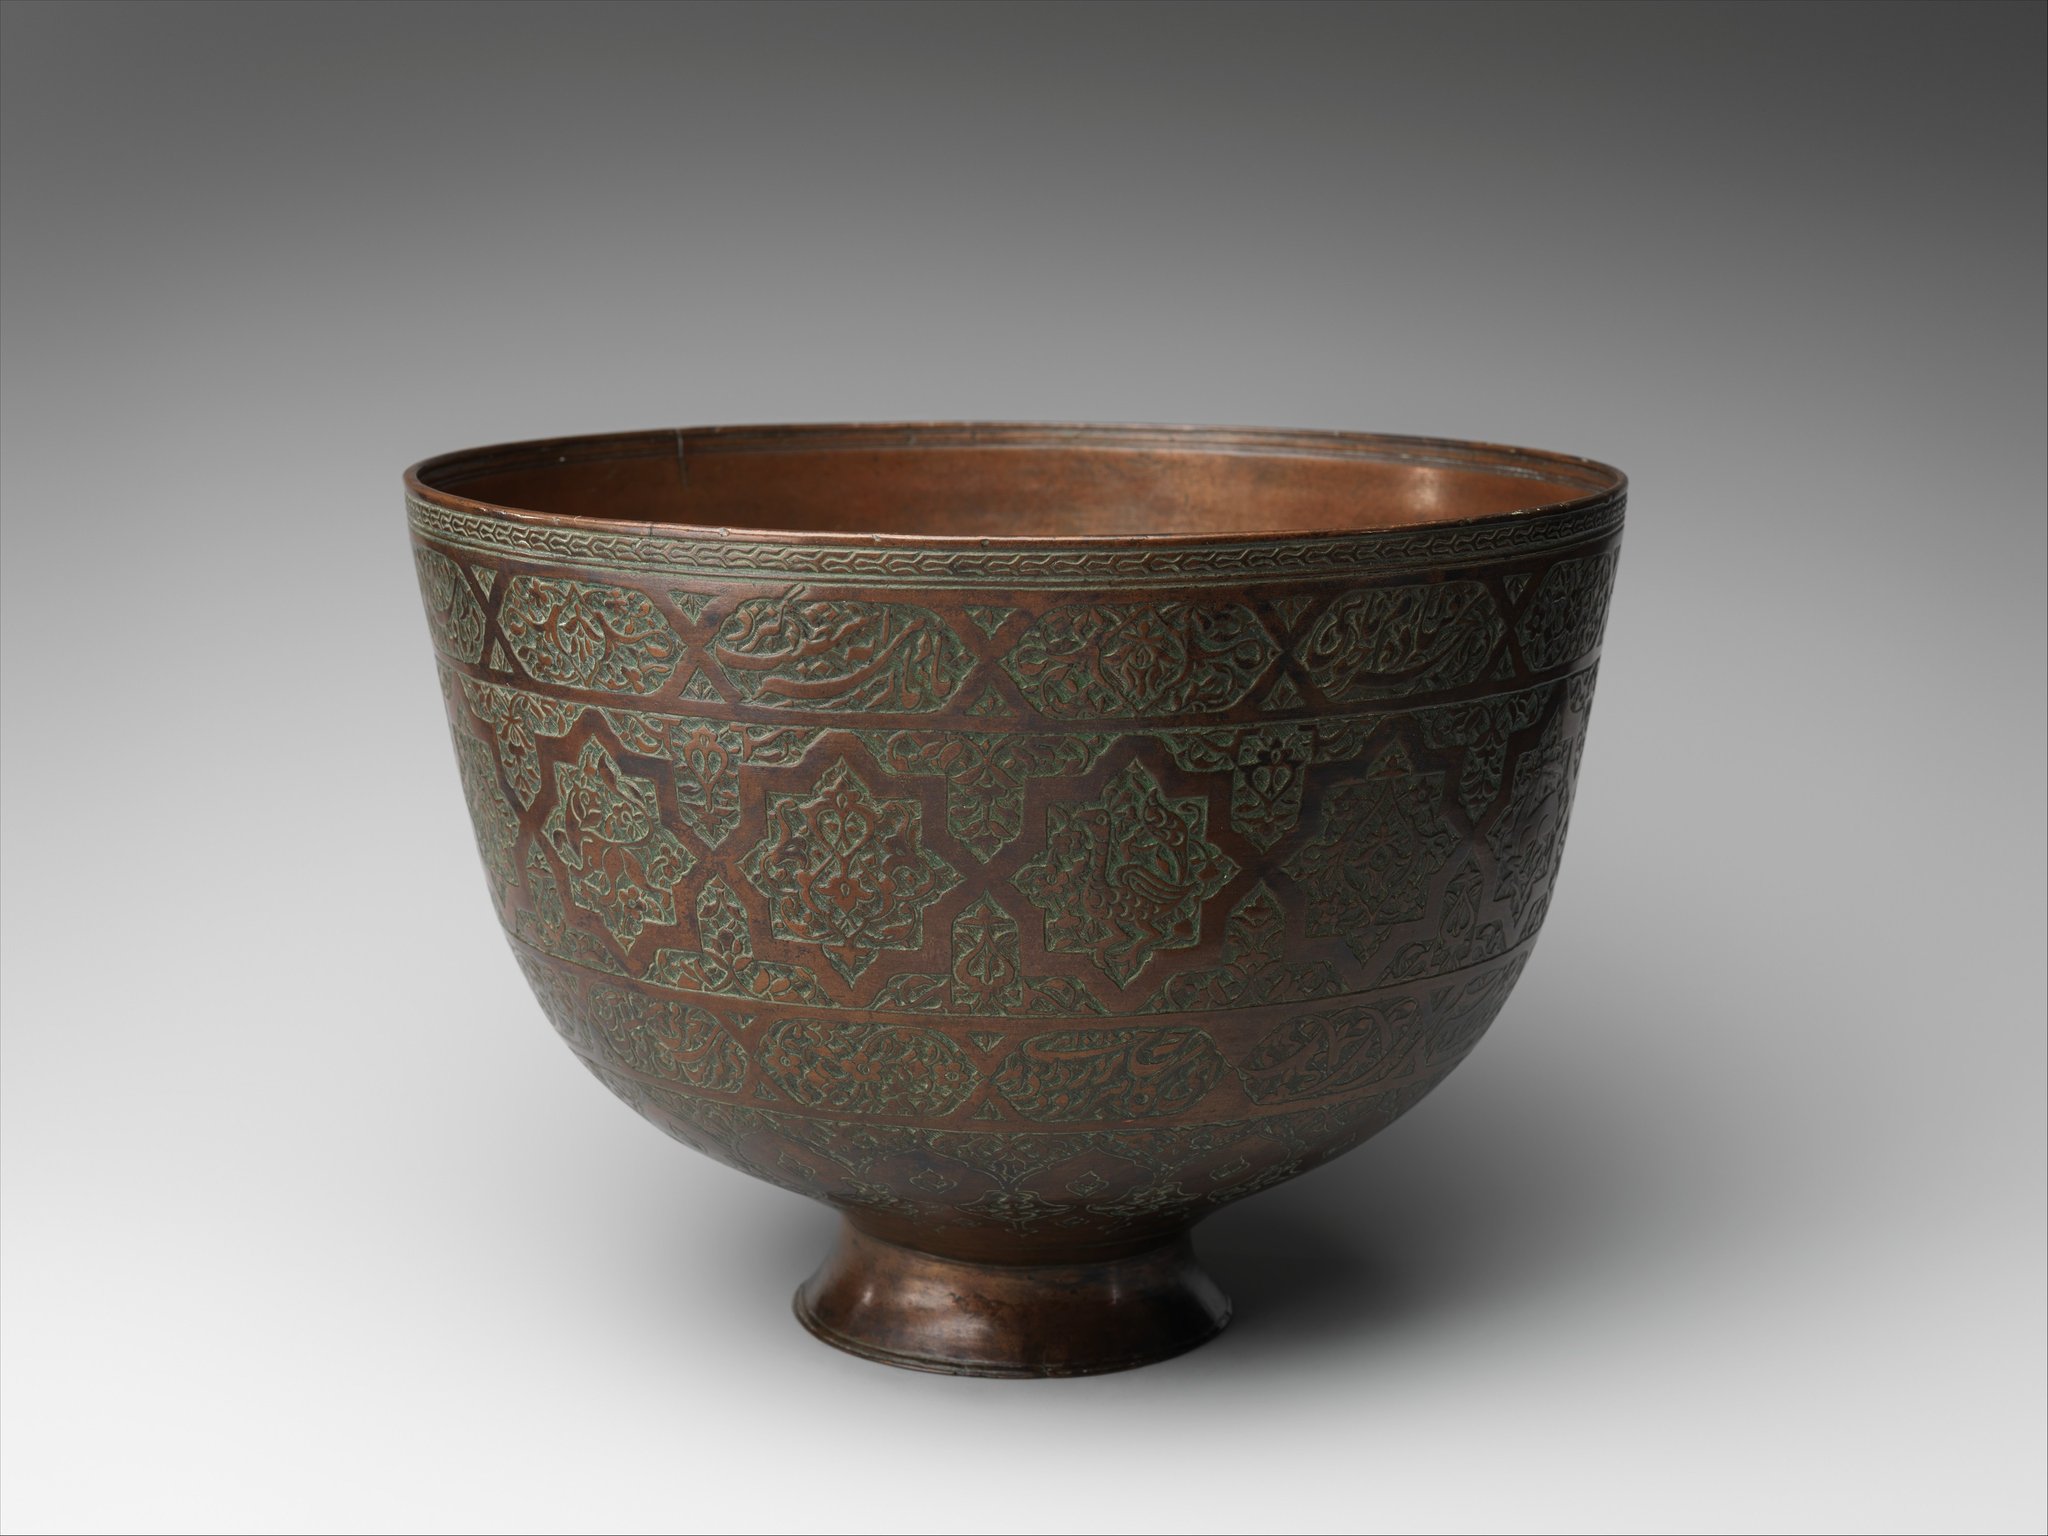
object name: bowl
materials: copper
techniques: chasing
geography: iran